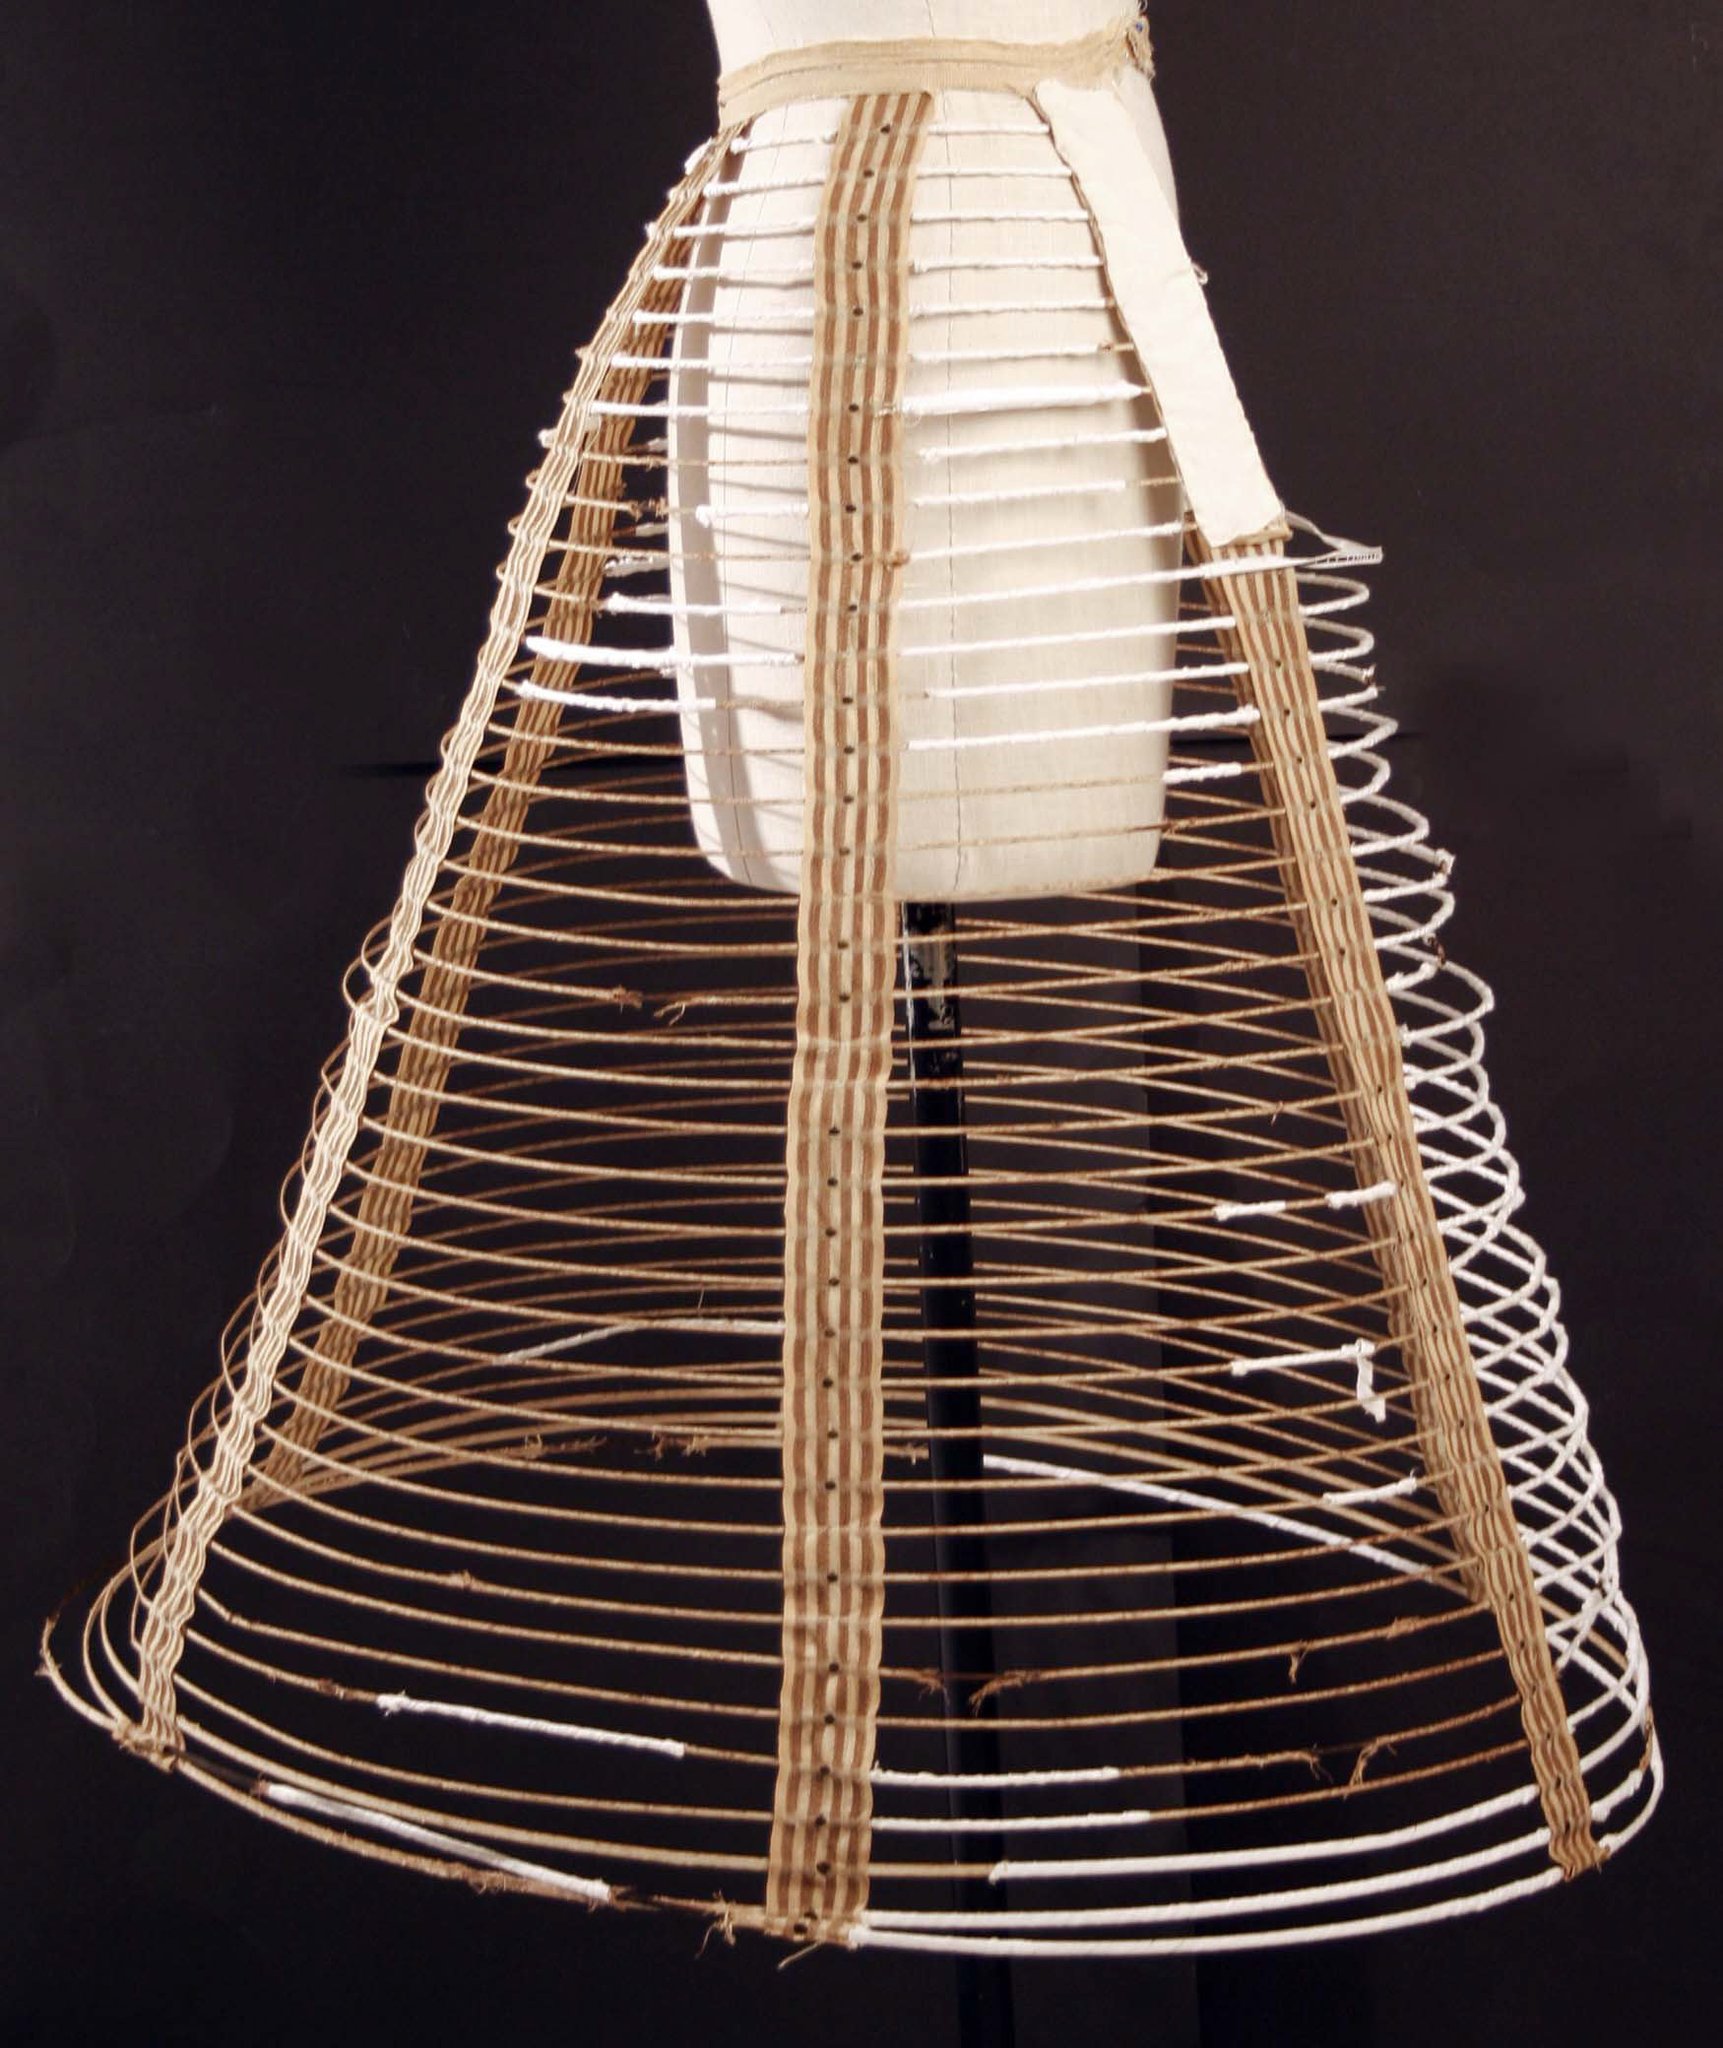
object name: cage crinoline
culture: american or european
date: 1834-1866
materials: metal